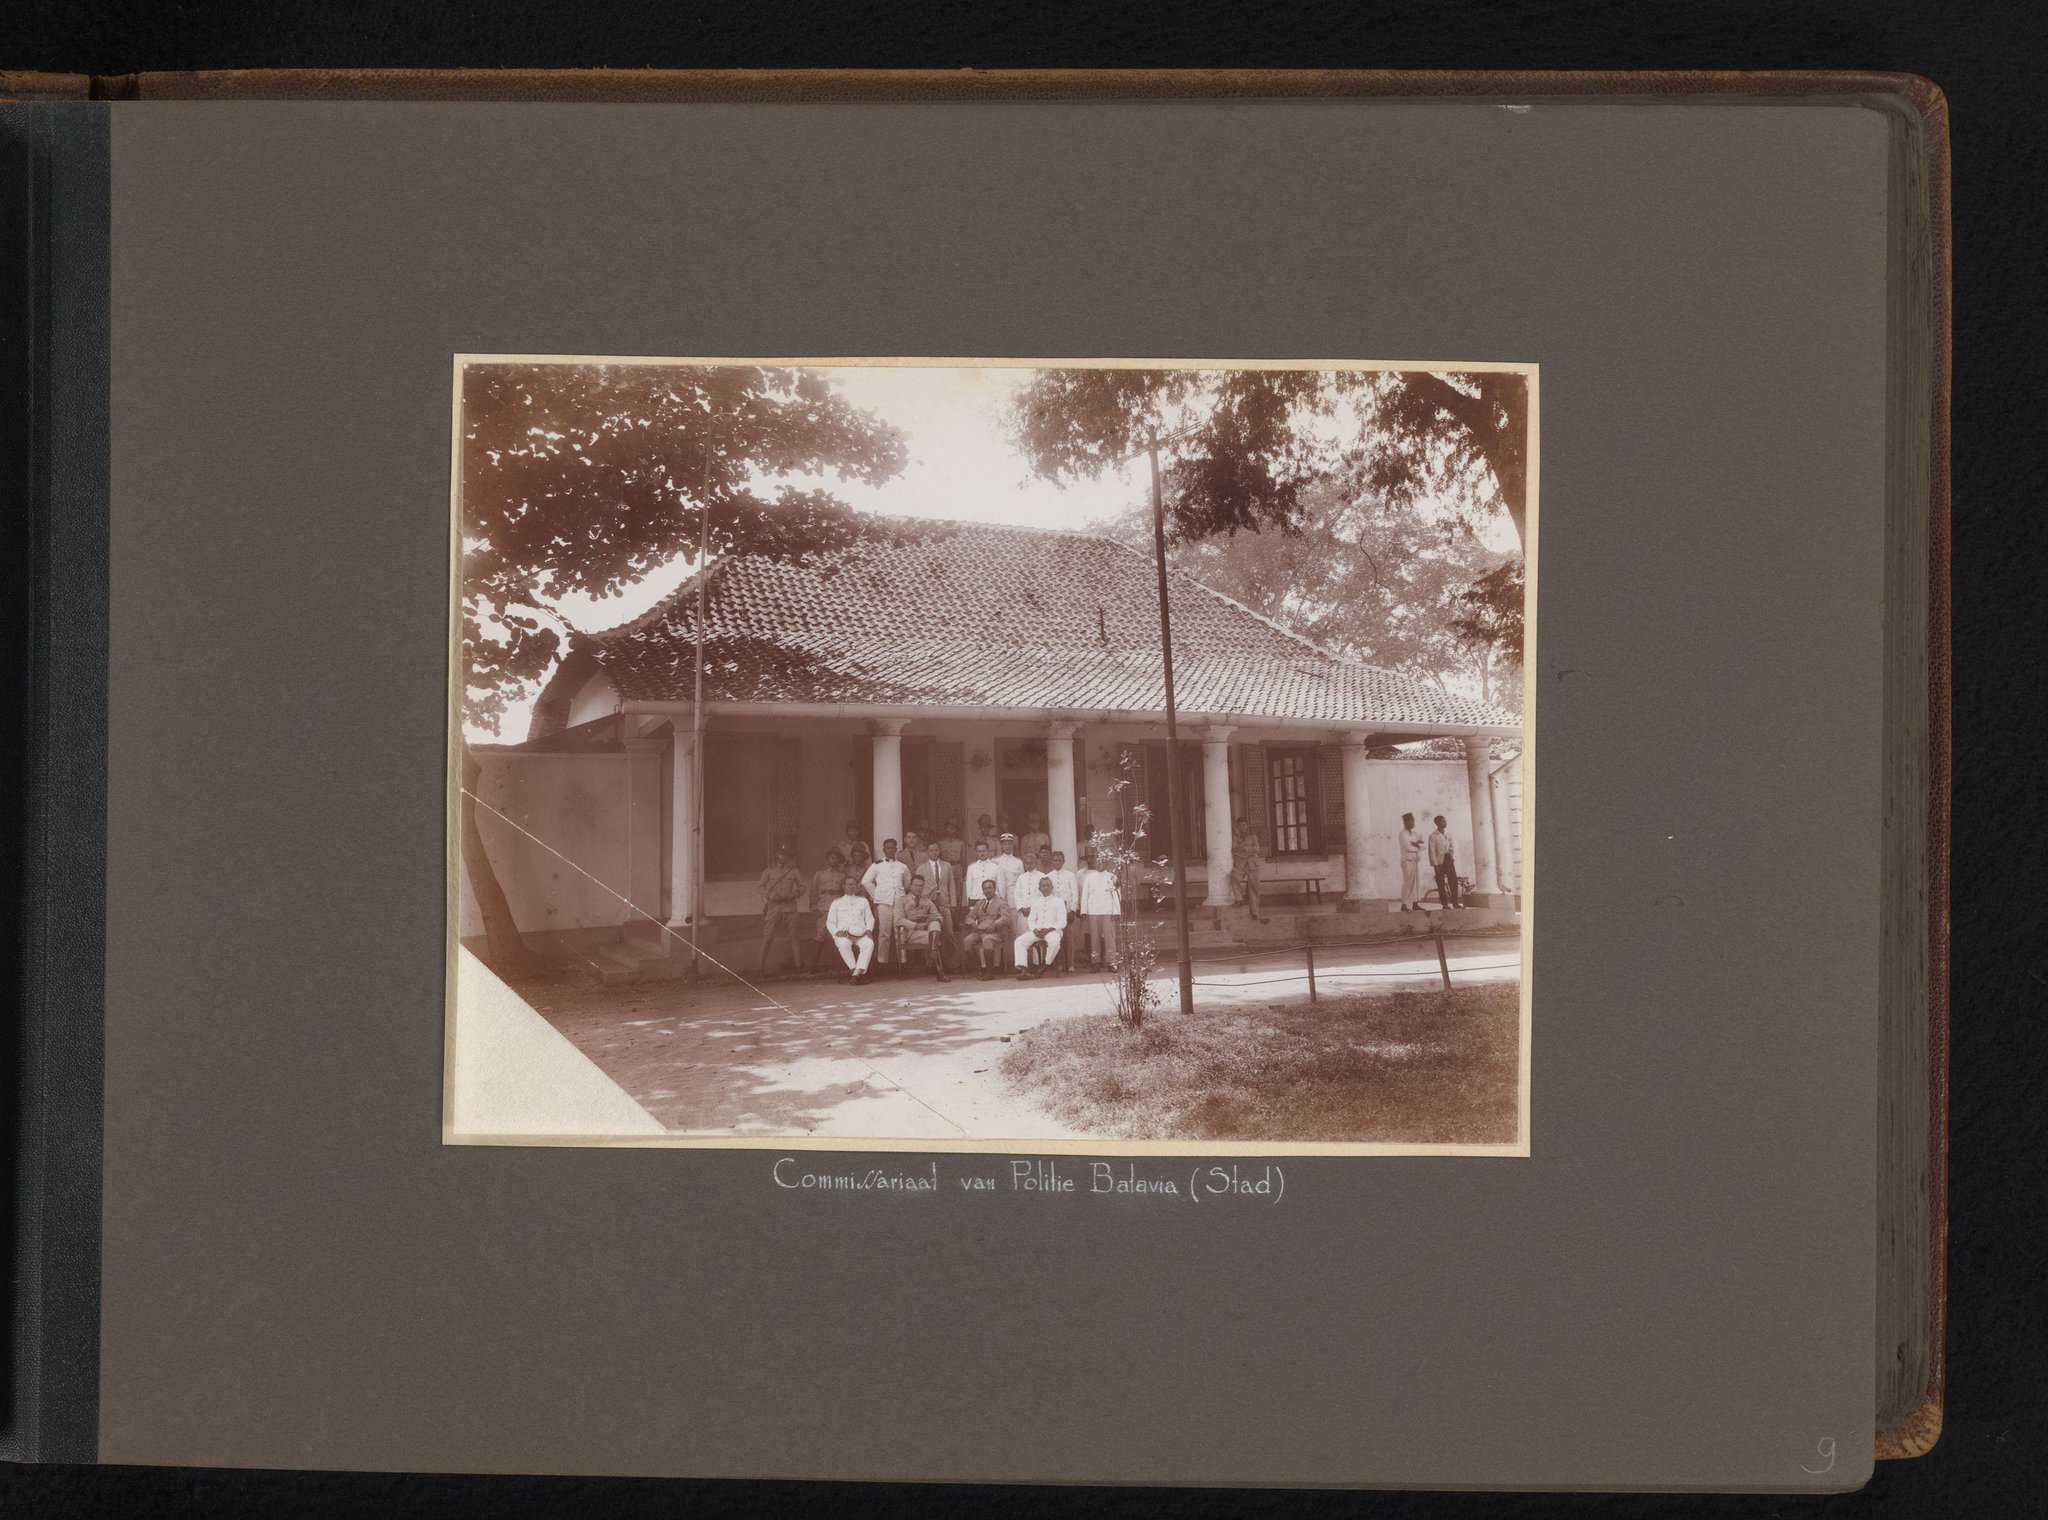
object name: photograph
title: Commissariaat van Politie Batavia (Stad)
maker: Anonymous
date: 1925-1931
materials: cardboard, photographic support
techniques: collodion silver print, gelatin silver print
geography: batavia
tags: dutch east indies, the, batavia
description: Albumblad met één foto: staf van het Commissariaat van Politie Batavia (Stad), poserend voor kantoor. Onderdeel van het fotoalbum aangeboden aan S. Koster door de Vereeniging van Hoogere Politie Ambtenaren in Nederlandsch-Indië in 1931.